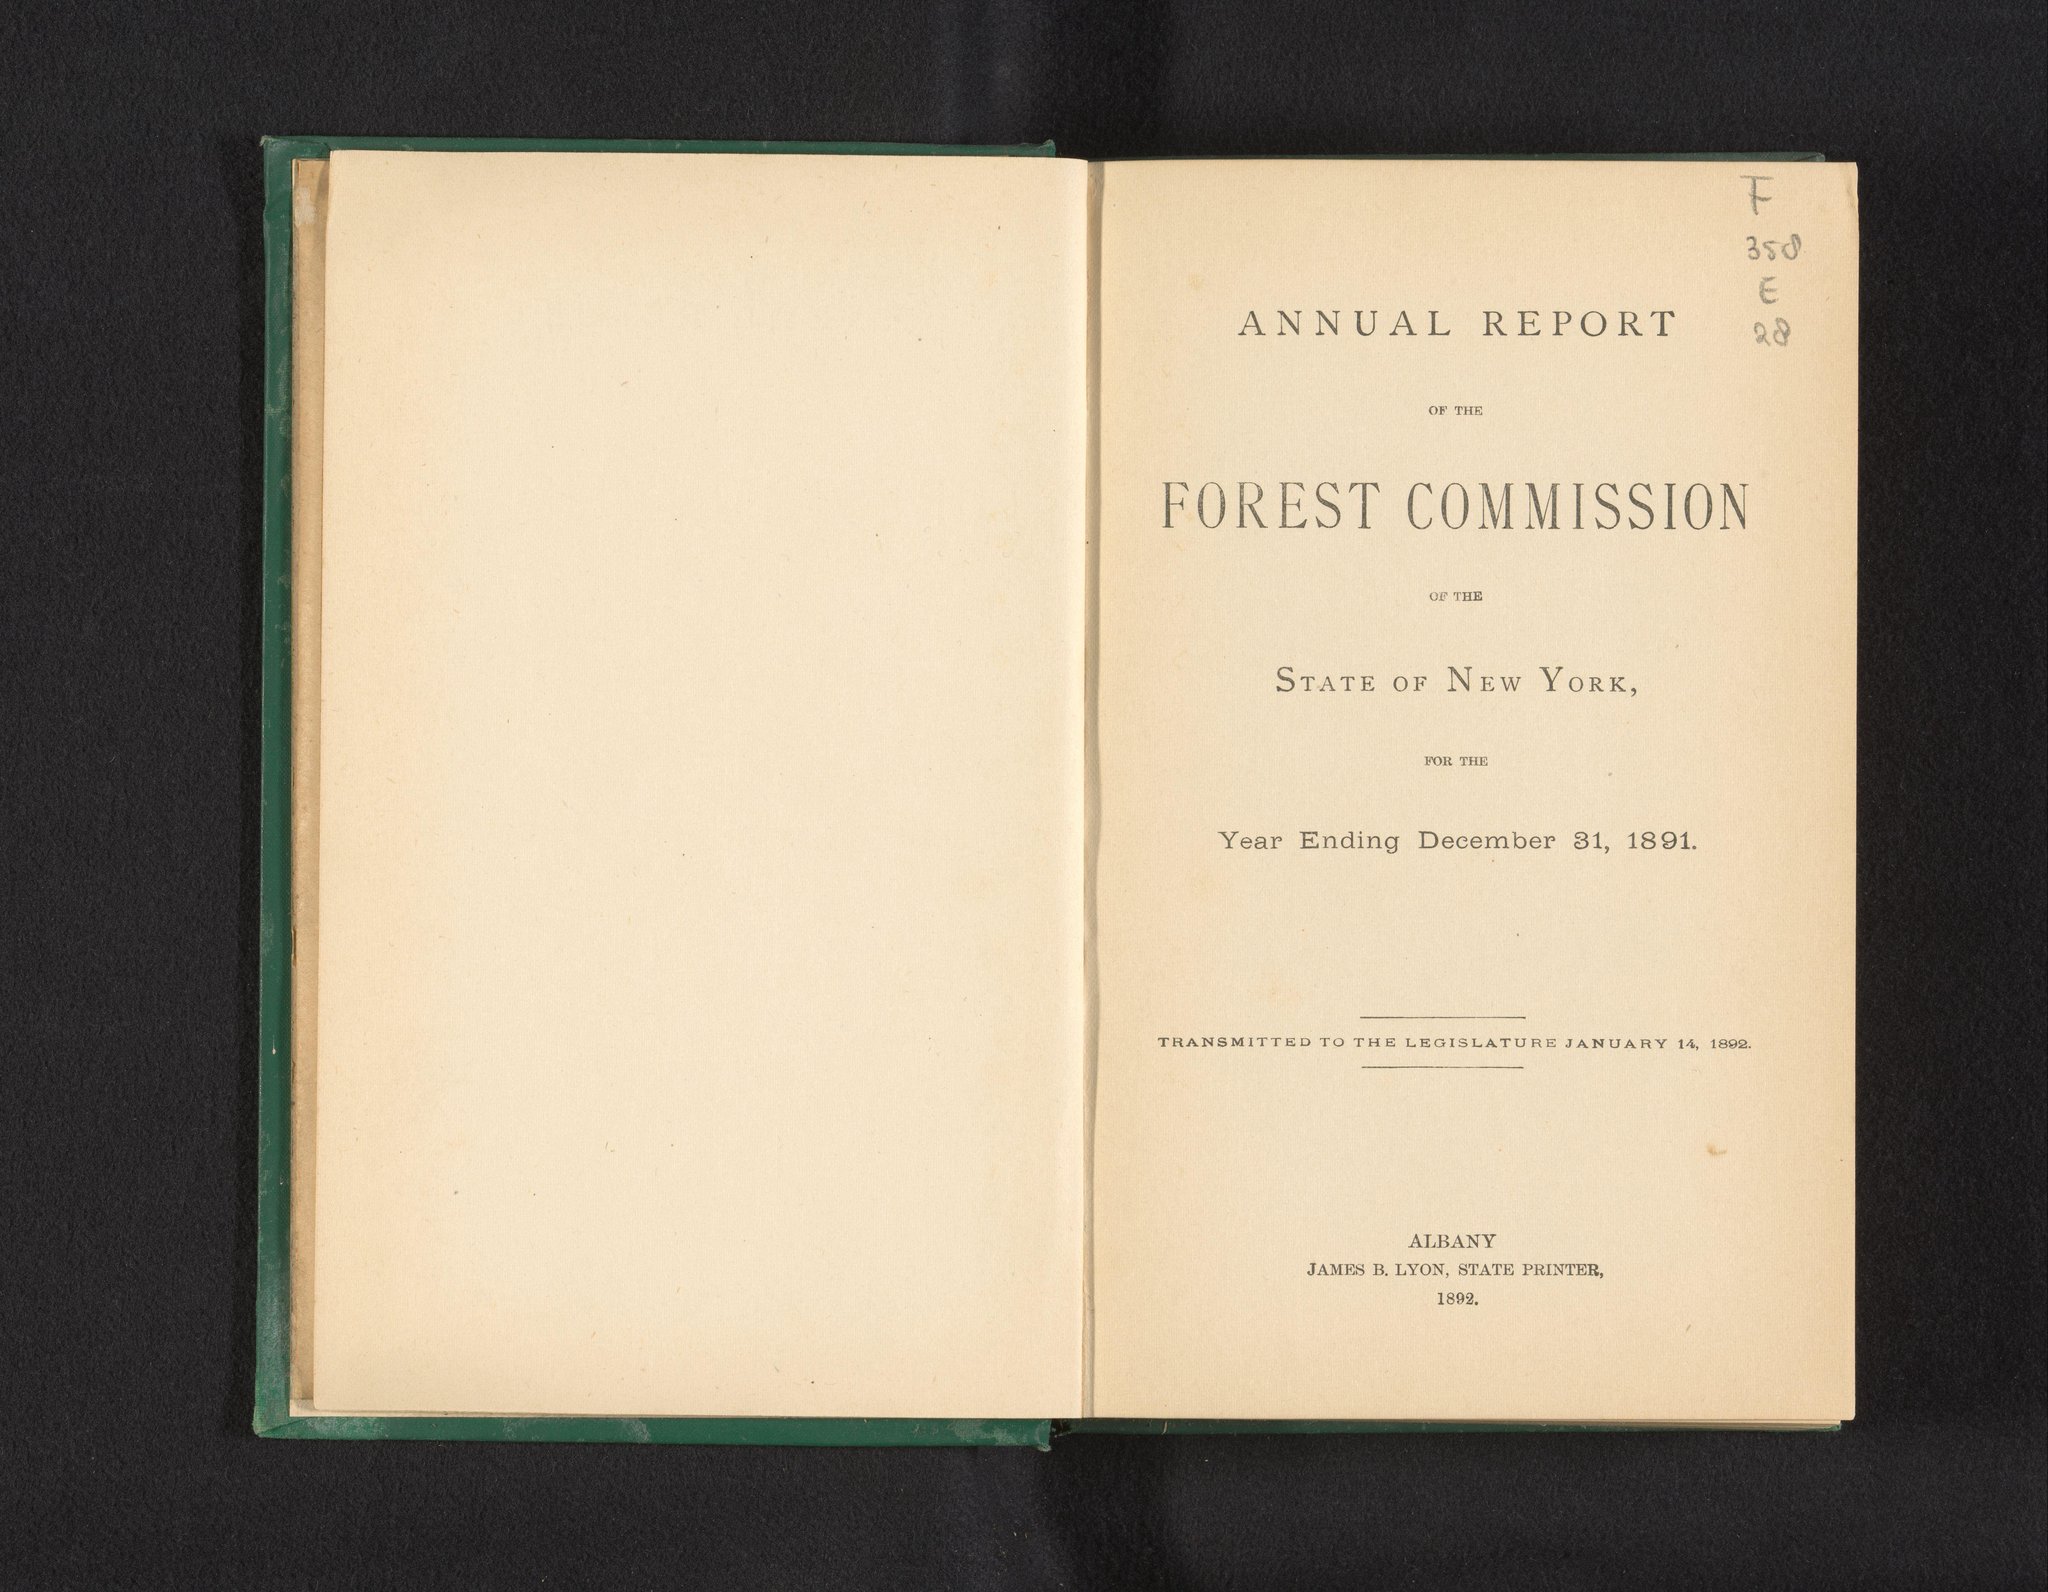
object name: book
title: Annual report of the Forest Commission of the State of New York for the year ending December 31, 1891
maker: james b. lyon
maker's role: printer, publisher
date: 1892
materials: cardboard, linen, paper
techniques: photograph, lithograph, printing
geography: albany